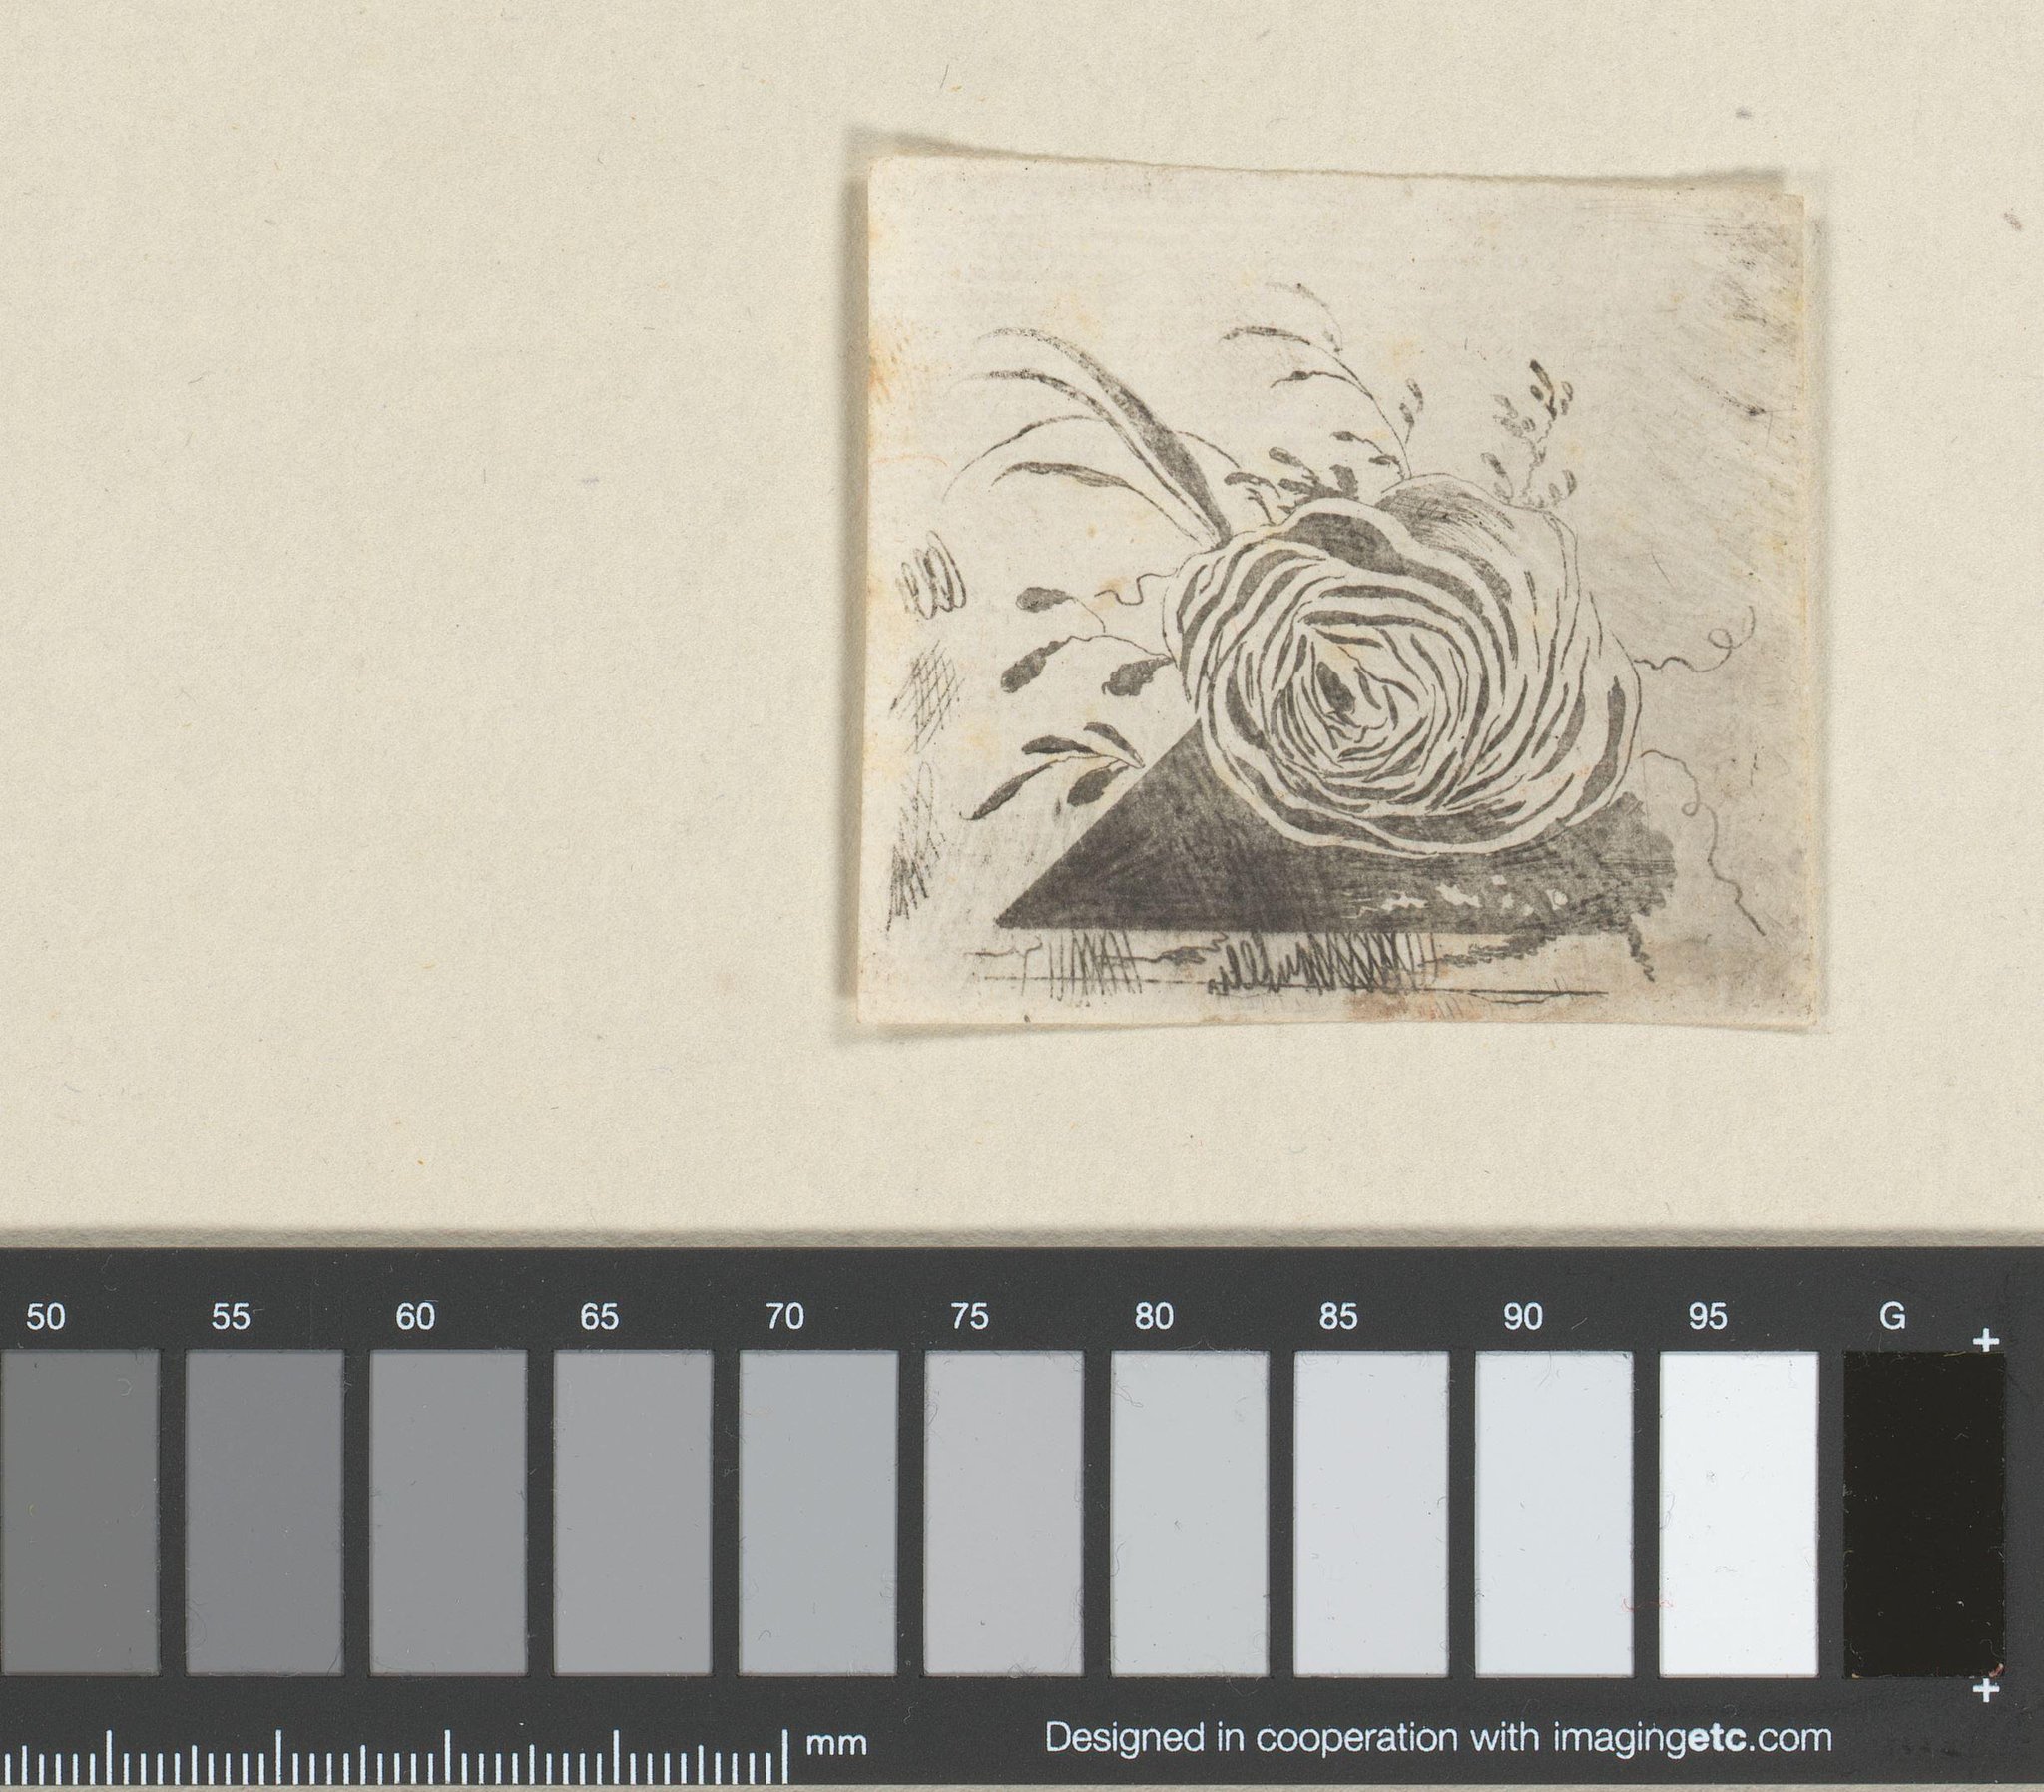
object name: print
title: Roos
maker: cornelis ploos van amstel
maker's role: draughtsman, print maker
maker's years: 1726-1798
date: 1736-1798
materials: paper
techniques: transfer, print drawing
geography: amsterdam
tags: flowers, flowers: rose